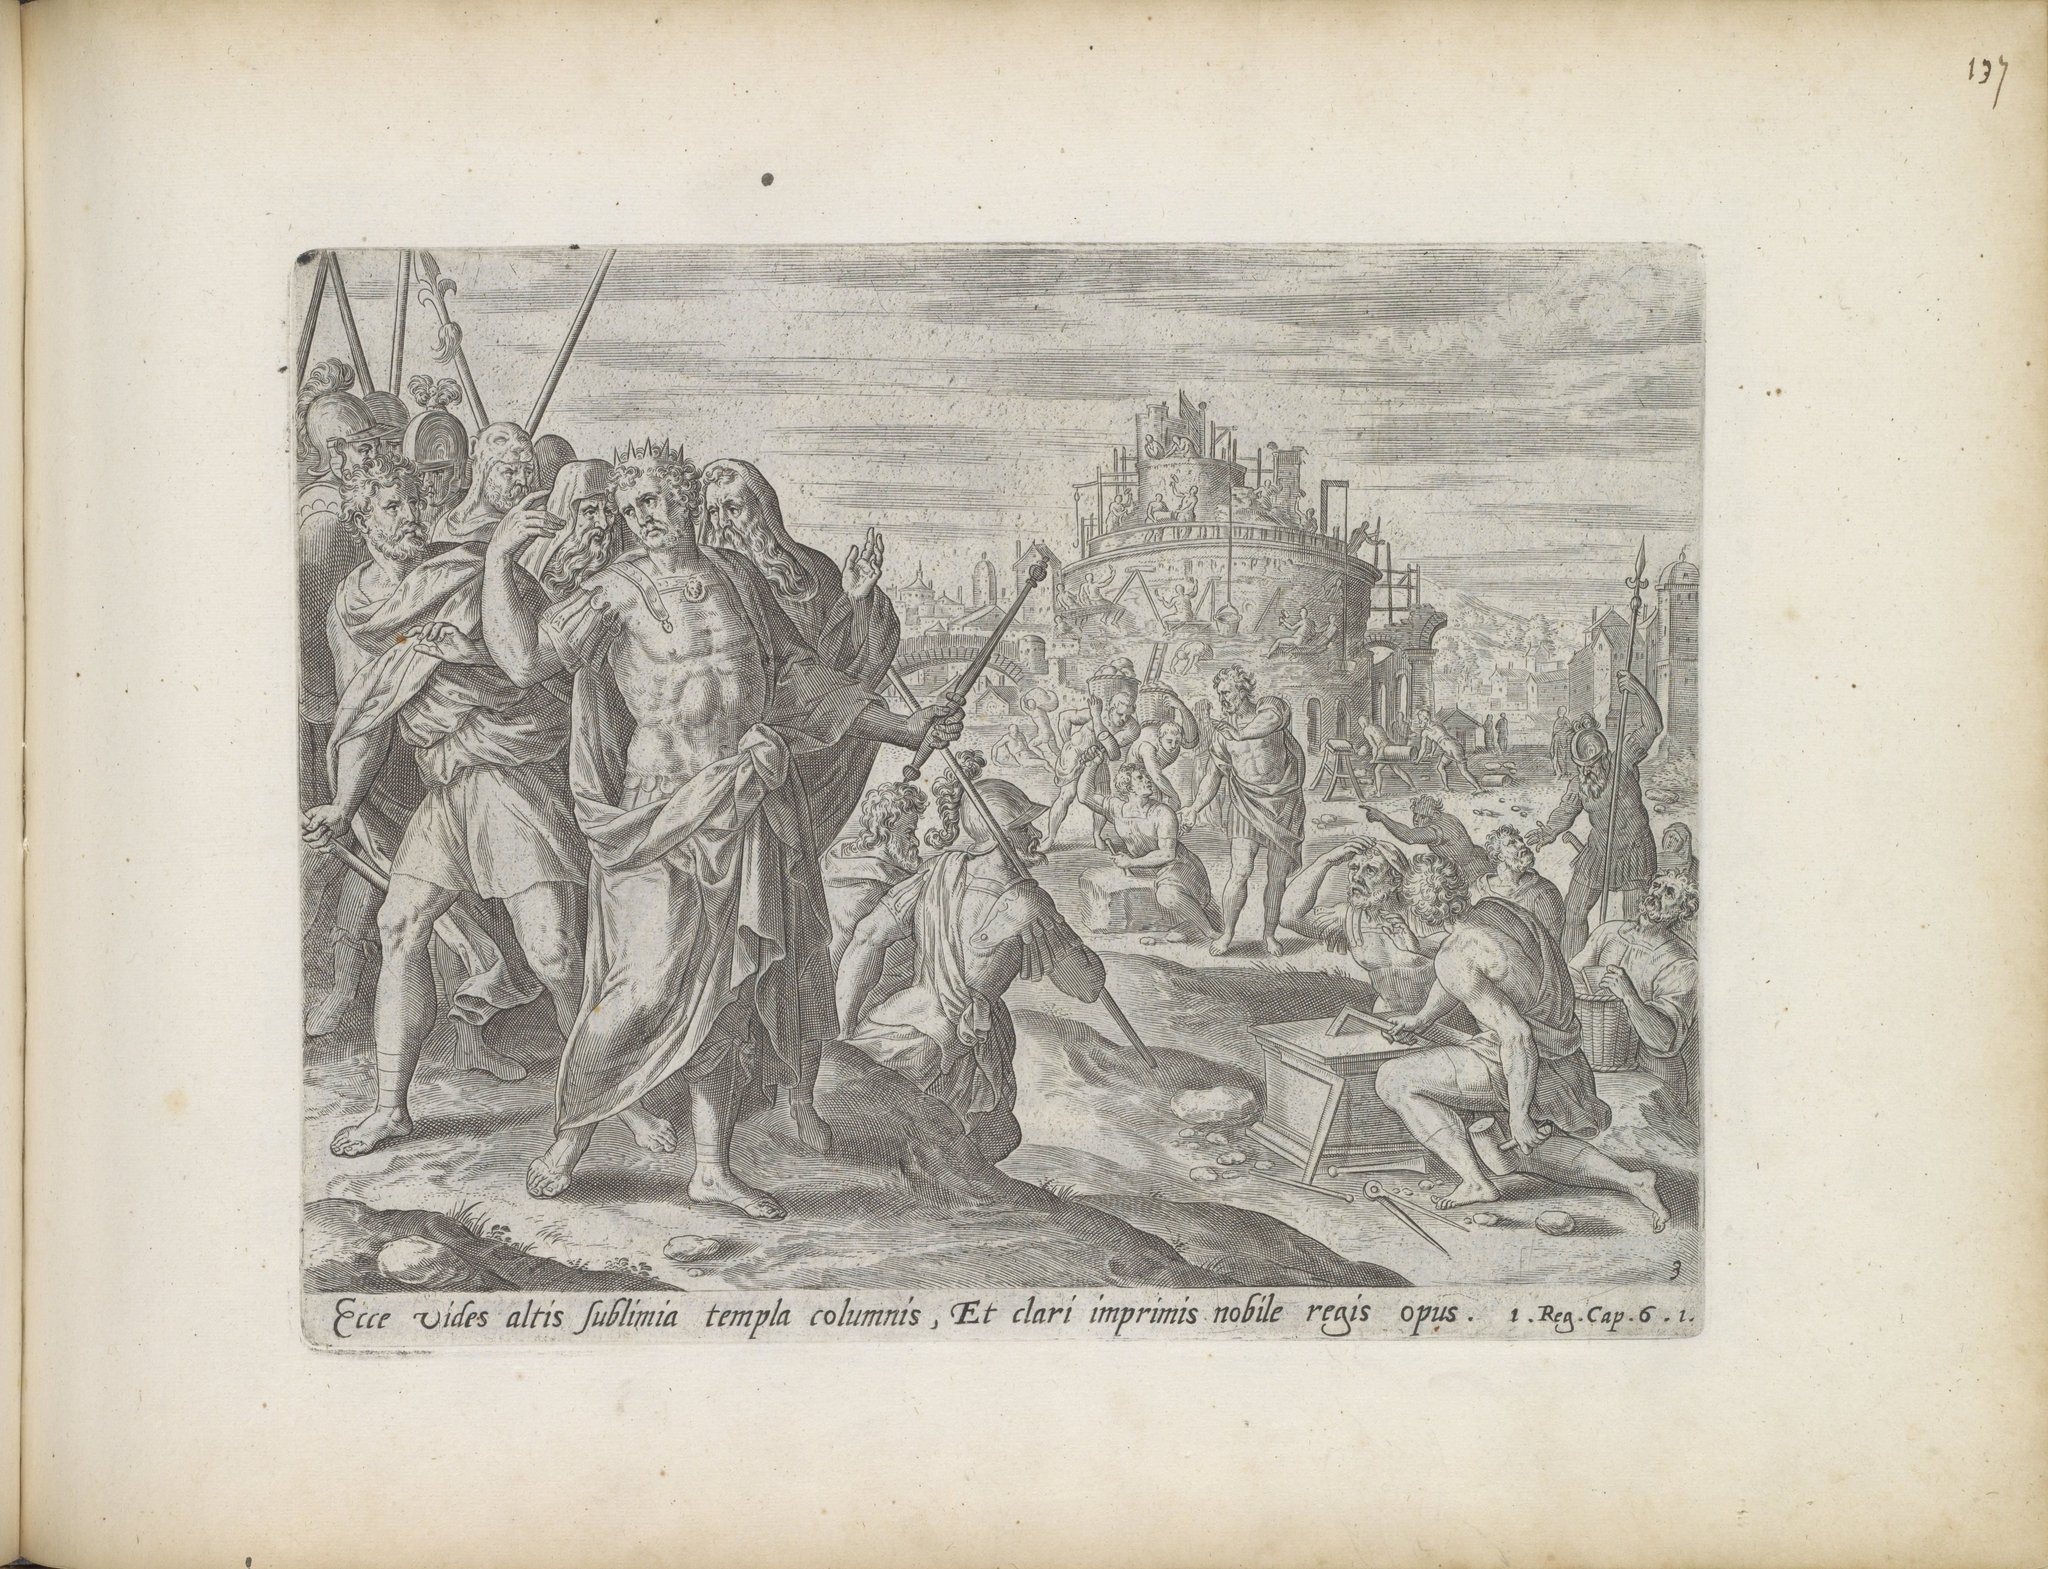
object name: print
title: Theatrum Biblicum Hoc Est Historiae Sacrae Veteris et Novi Testamenti Tabulis Aeneis Expressae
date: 1579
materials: paper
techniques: engraving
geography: amsterdam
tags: solomon supervising the work ~ temple of solomon, building-site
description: Koning Salomo laat de tempel in Jeruzalem bouwen. Hij staat links op de voorgrond met een scepter in zijn hand. Op de achtergrond de bouwplaats. Onder de voorstelling een verwijzing in het Latijn naar de Bijbeltekst in 1 Kon. 6:1. Deze prent maakt deel uit van een album.